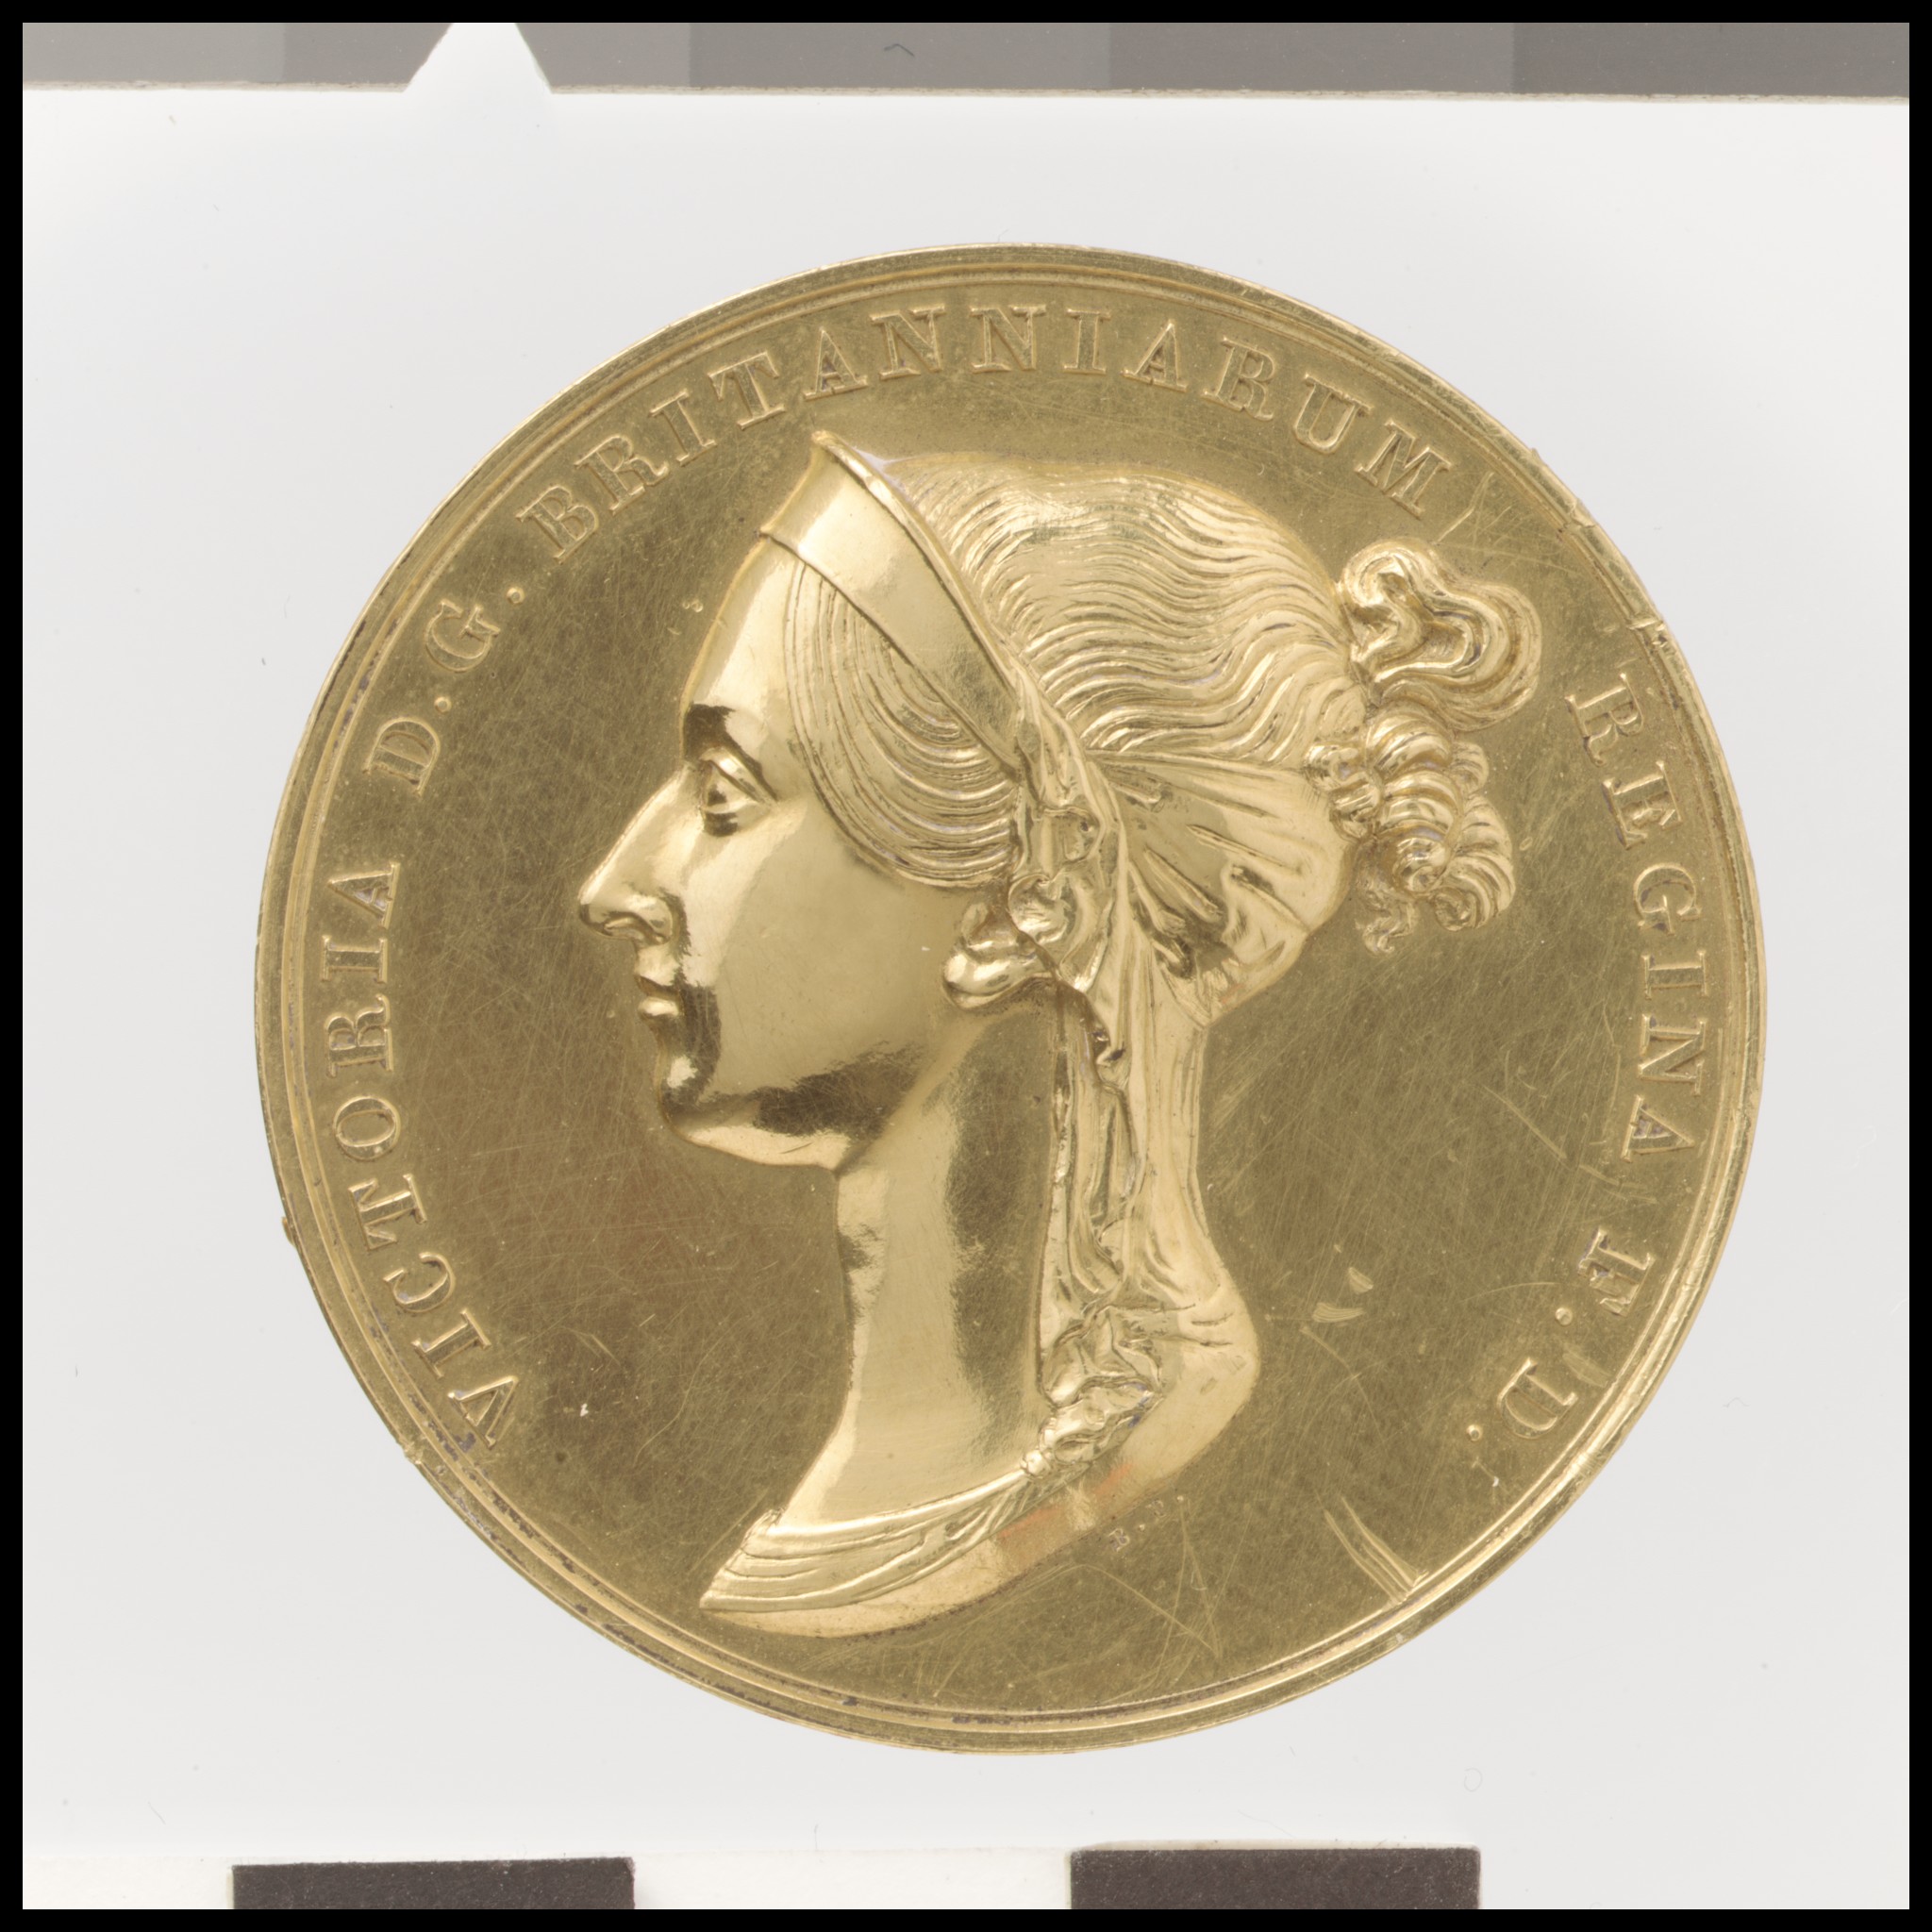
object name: medal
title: Coronation of Queen Victoria (1819–1901)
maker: benedetto pistrucci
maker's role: maker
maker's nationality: italian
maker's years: 1783-1855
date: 1838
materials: gold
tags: profiles,women,queen victoria